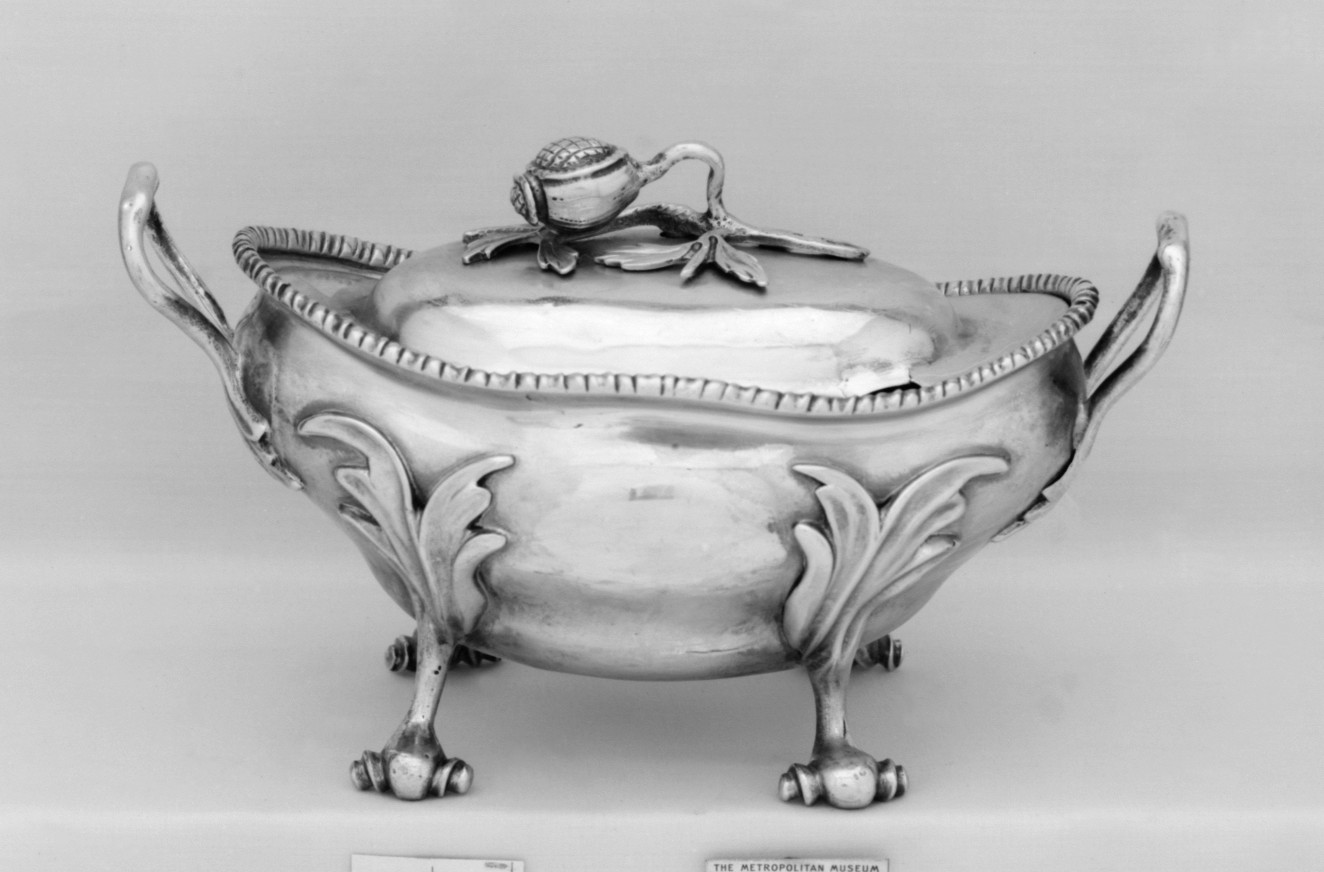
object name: sauce tureen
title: Sauce-tureen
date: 1767-1768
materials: silver